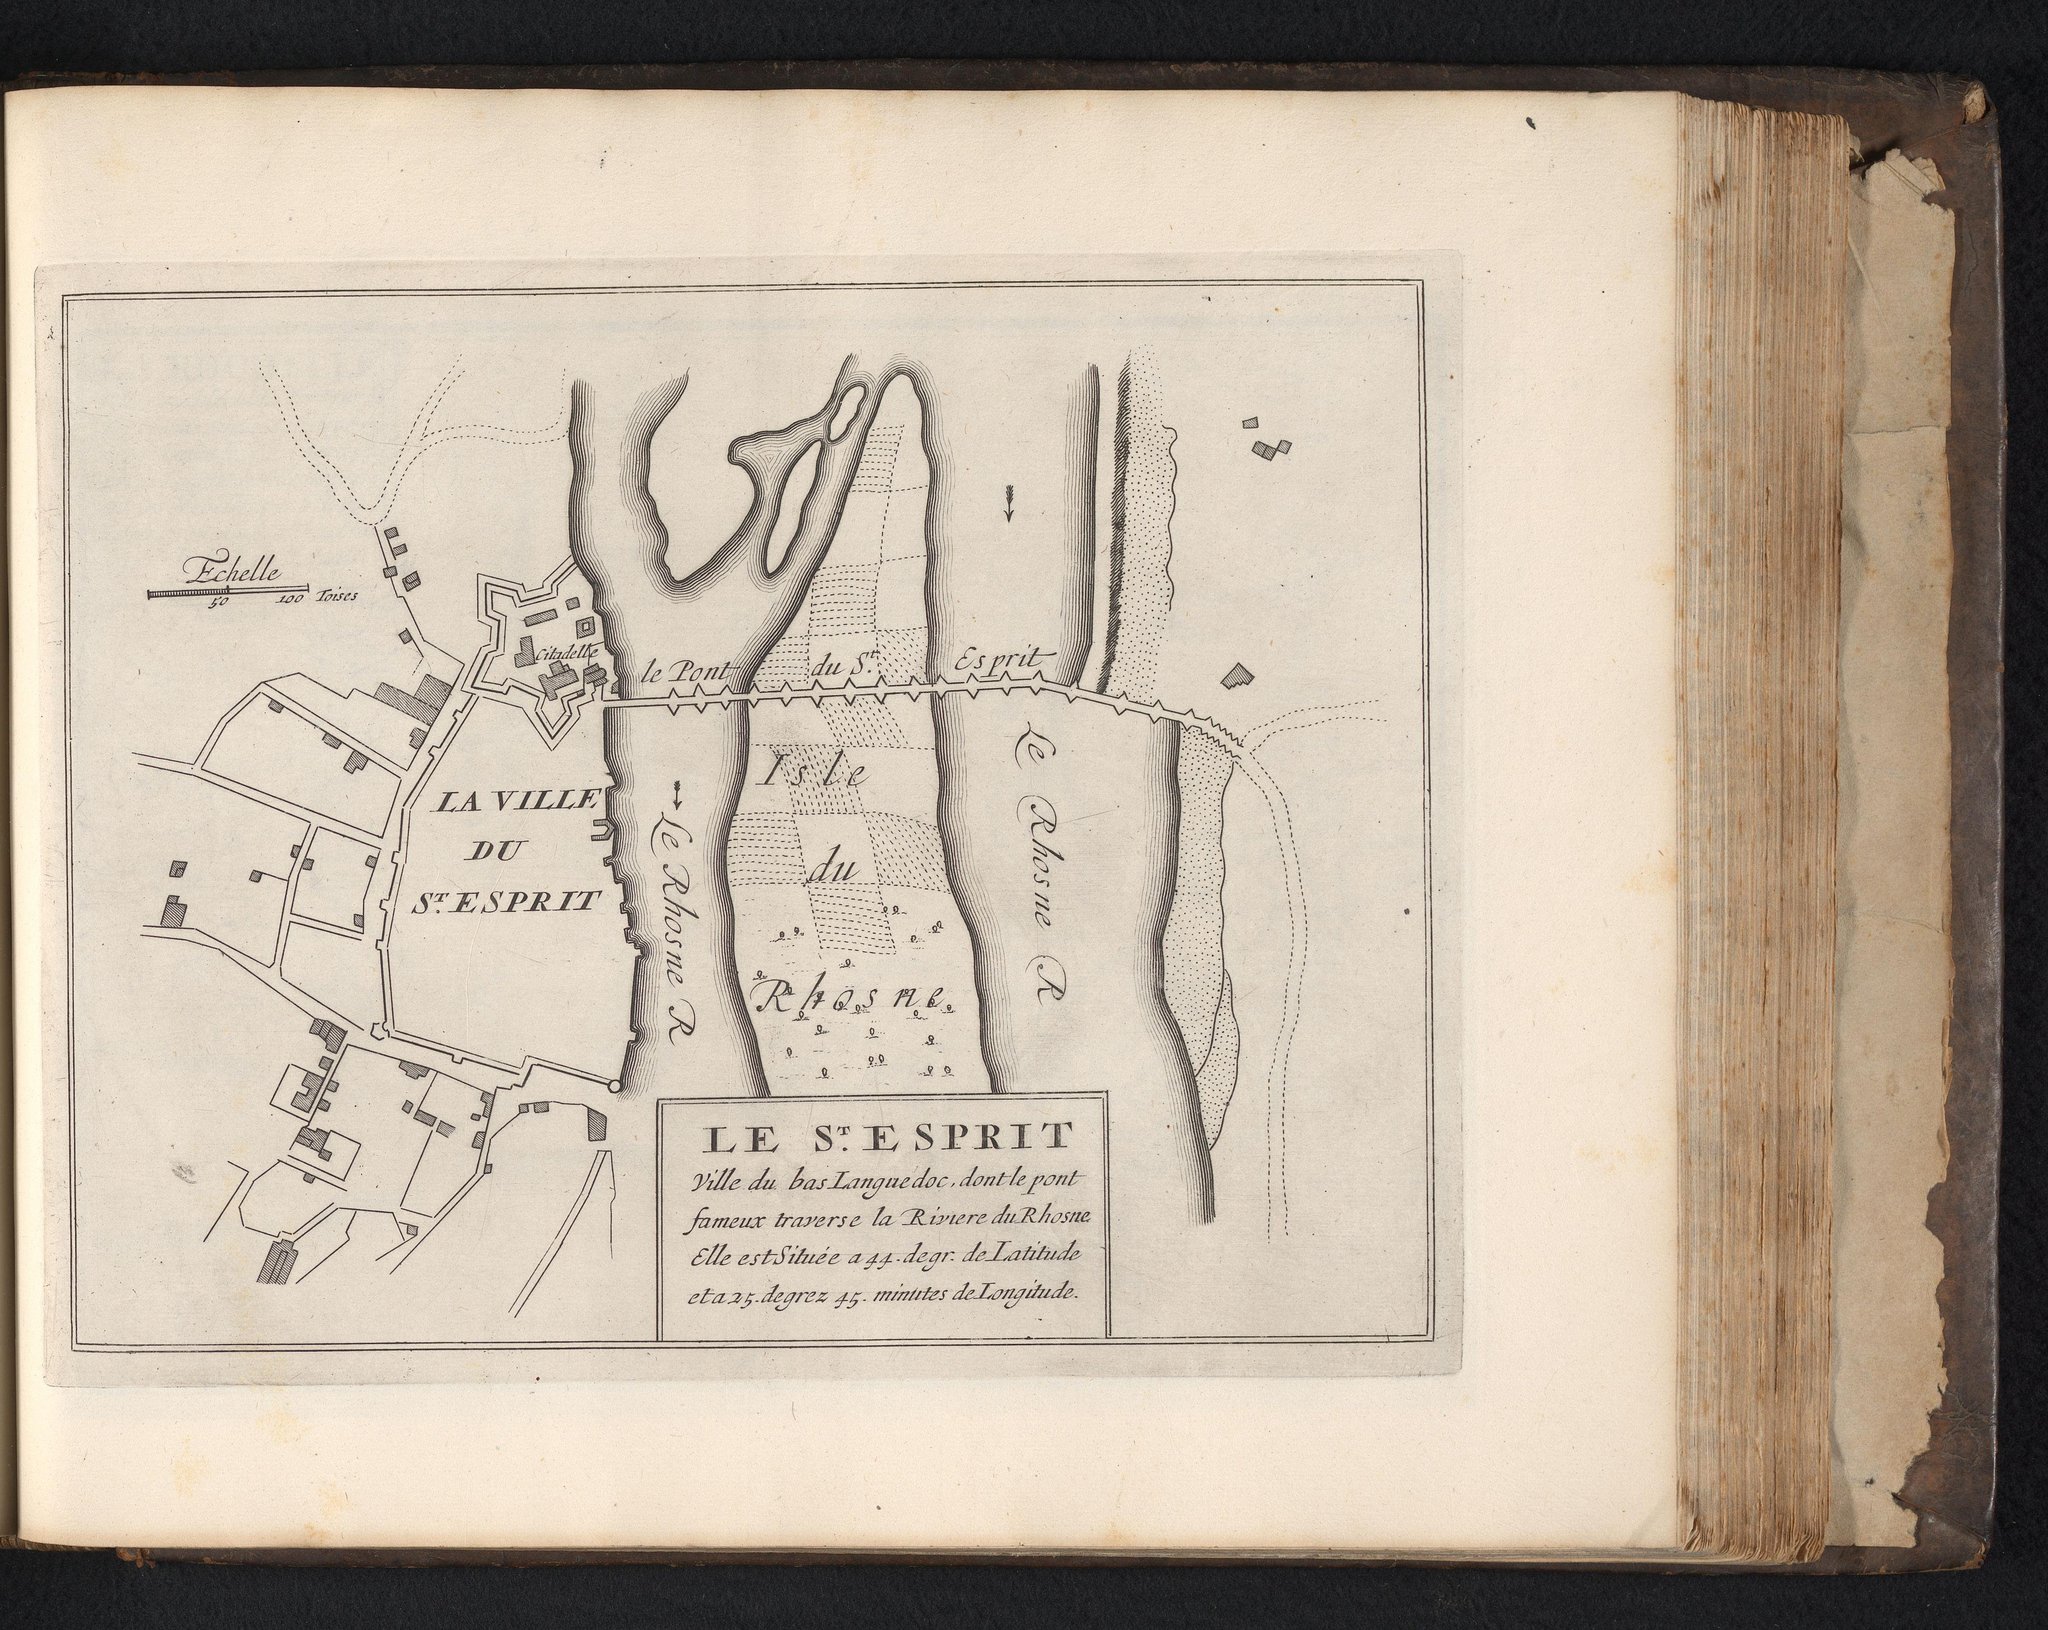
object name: print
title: Plattegrond van Pont-Saint-Esprit, ca. 1695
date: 1695-1697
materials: paper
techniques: etching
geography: france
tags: fortress, maps of cities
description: Plattegrond van de versterkingen om de Franse stad Pont-Saint-Esprit met de brug over de Rhône. Onderdeel van het achtste deel (1697) van het prentwerk waarin gebundeld zijn de acht delen van Les forces de l'Europe uitgegeven tussen 1693-1697. Het prentwerk bestaat uit 175 platen met plannen (afkomstig van Sébastien Le Prestre, Seigneur de Vauban) van vermaarde sterke steden en vestingen in de Negenjarige Oorlog. Titel en opschriften in het Frans.